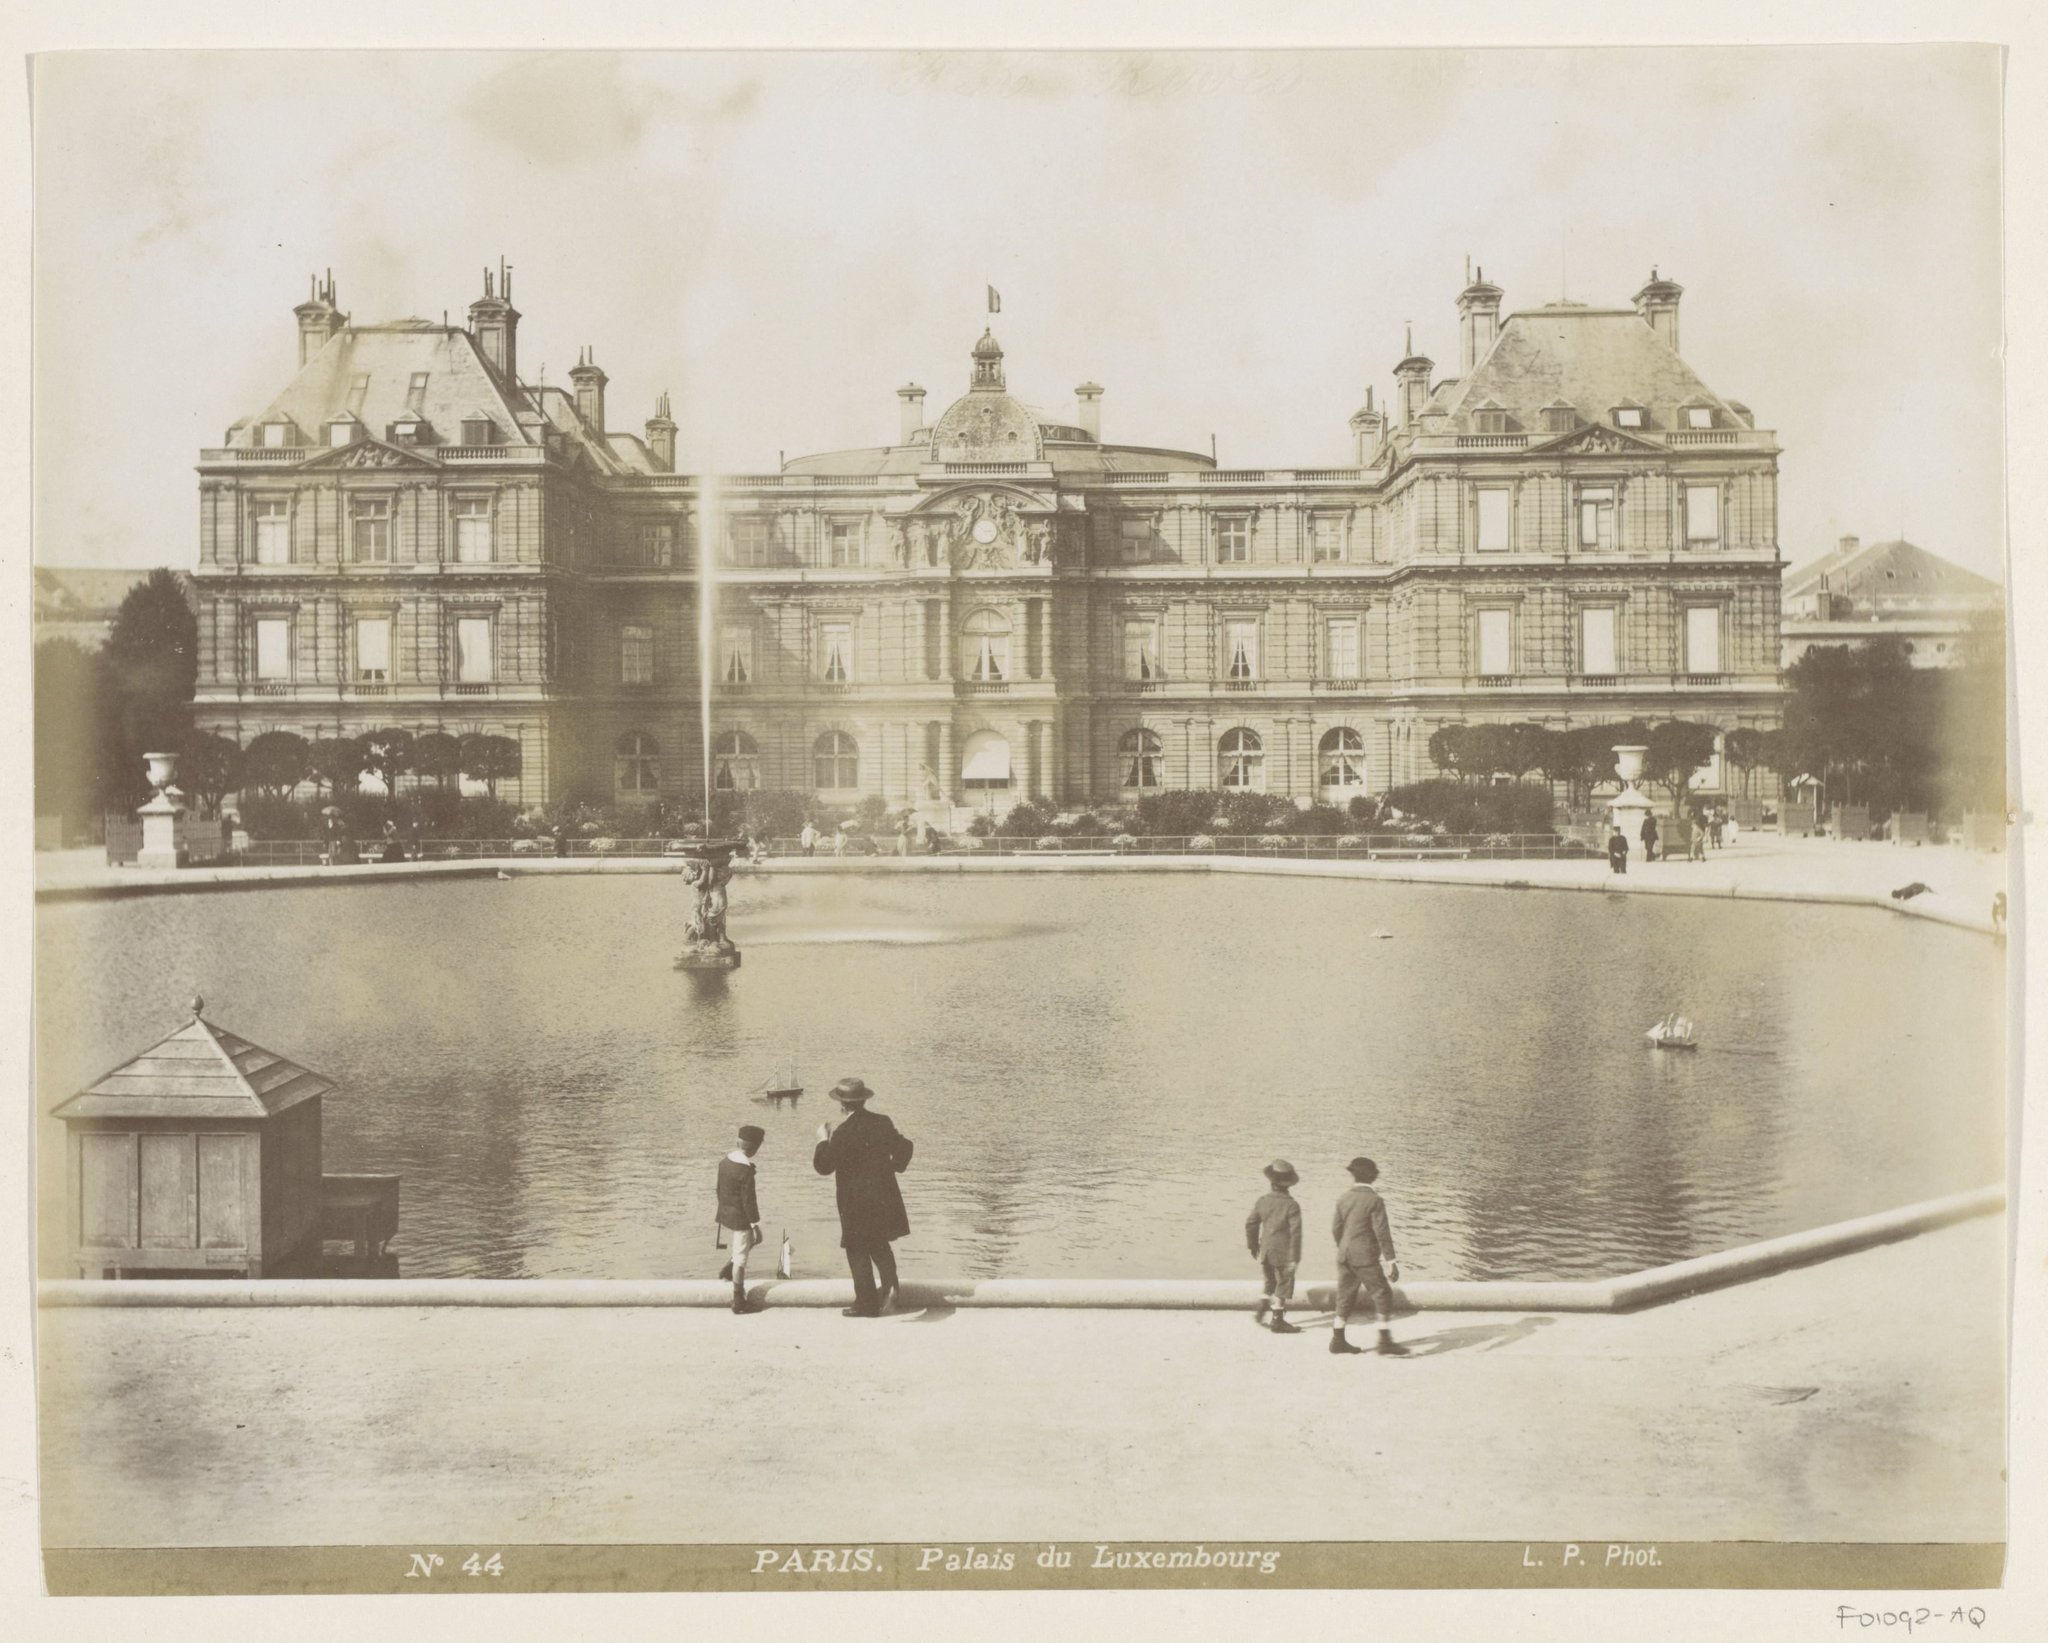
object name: photograph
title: Vijver met spelende kinderen bij het Palais du Luxembourg (zuidgevel) in Parijs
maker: louis antoine pamard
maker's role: fotograaf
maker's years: 1840-1893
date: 1880-1900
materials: cardboard, paper, photographic support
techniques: albumen print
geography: paris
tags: child, palace, pond, pool, façade (of house or building)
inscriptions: negative number: ‘44’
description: Onderdeel van Reisalbum met foto's van bezienswaardigheden in België en Frankrijk.